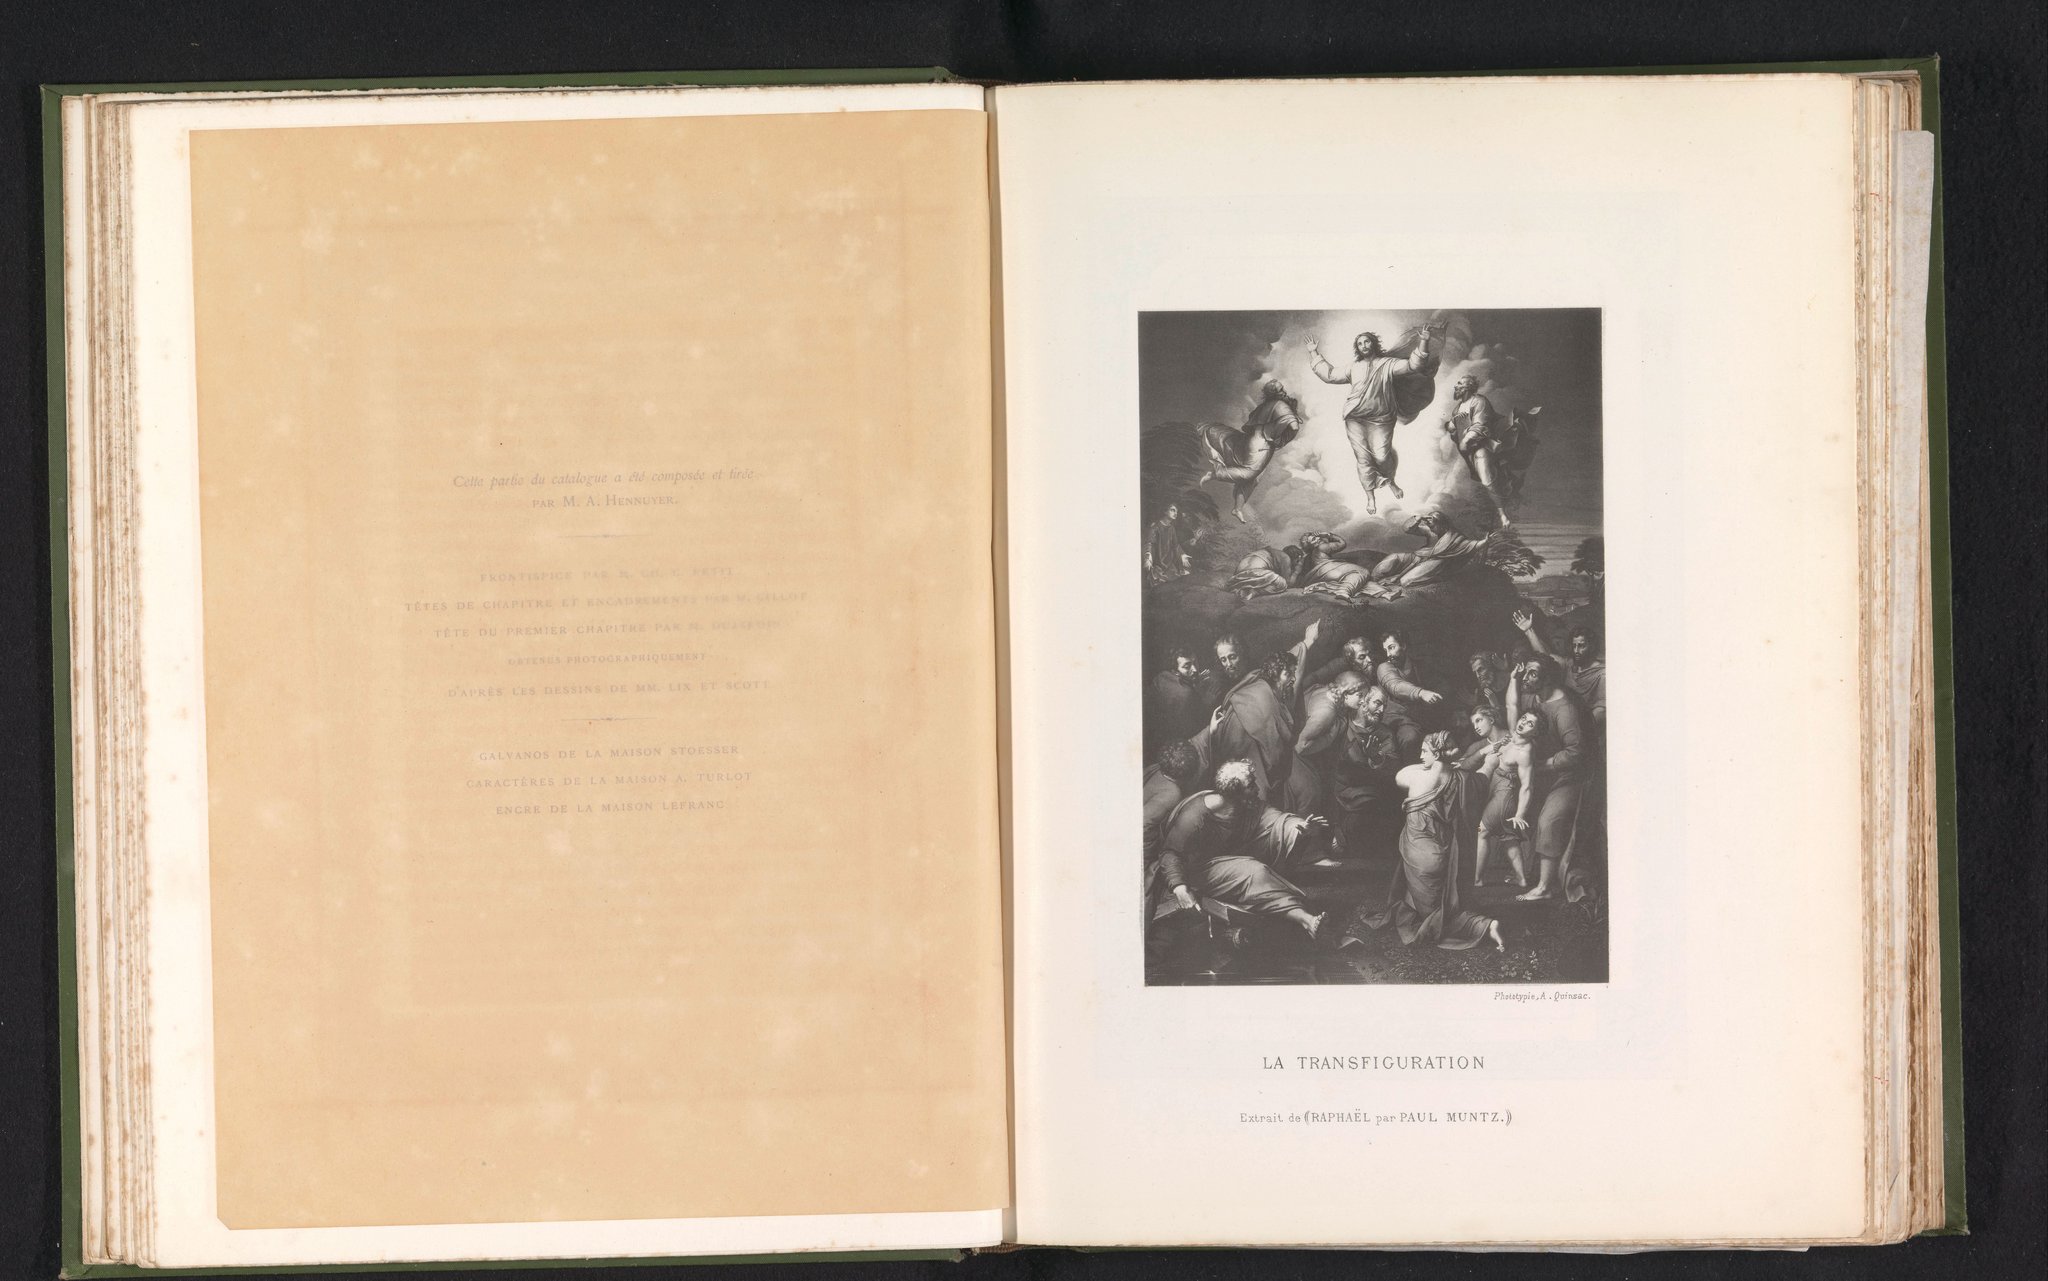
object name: reproduction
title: Fotoreproductie van een prent, voorstellende de Transfiguratie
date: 1871-1881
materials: paper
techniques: photograph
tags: the transfiguration: moses and elijah appear on either side of christ on mount tabor (matthew 17:1-13; mark 9:2-13; luke 9:28-36)